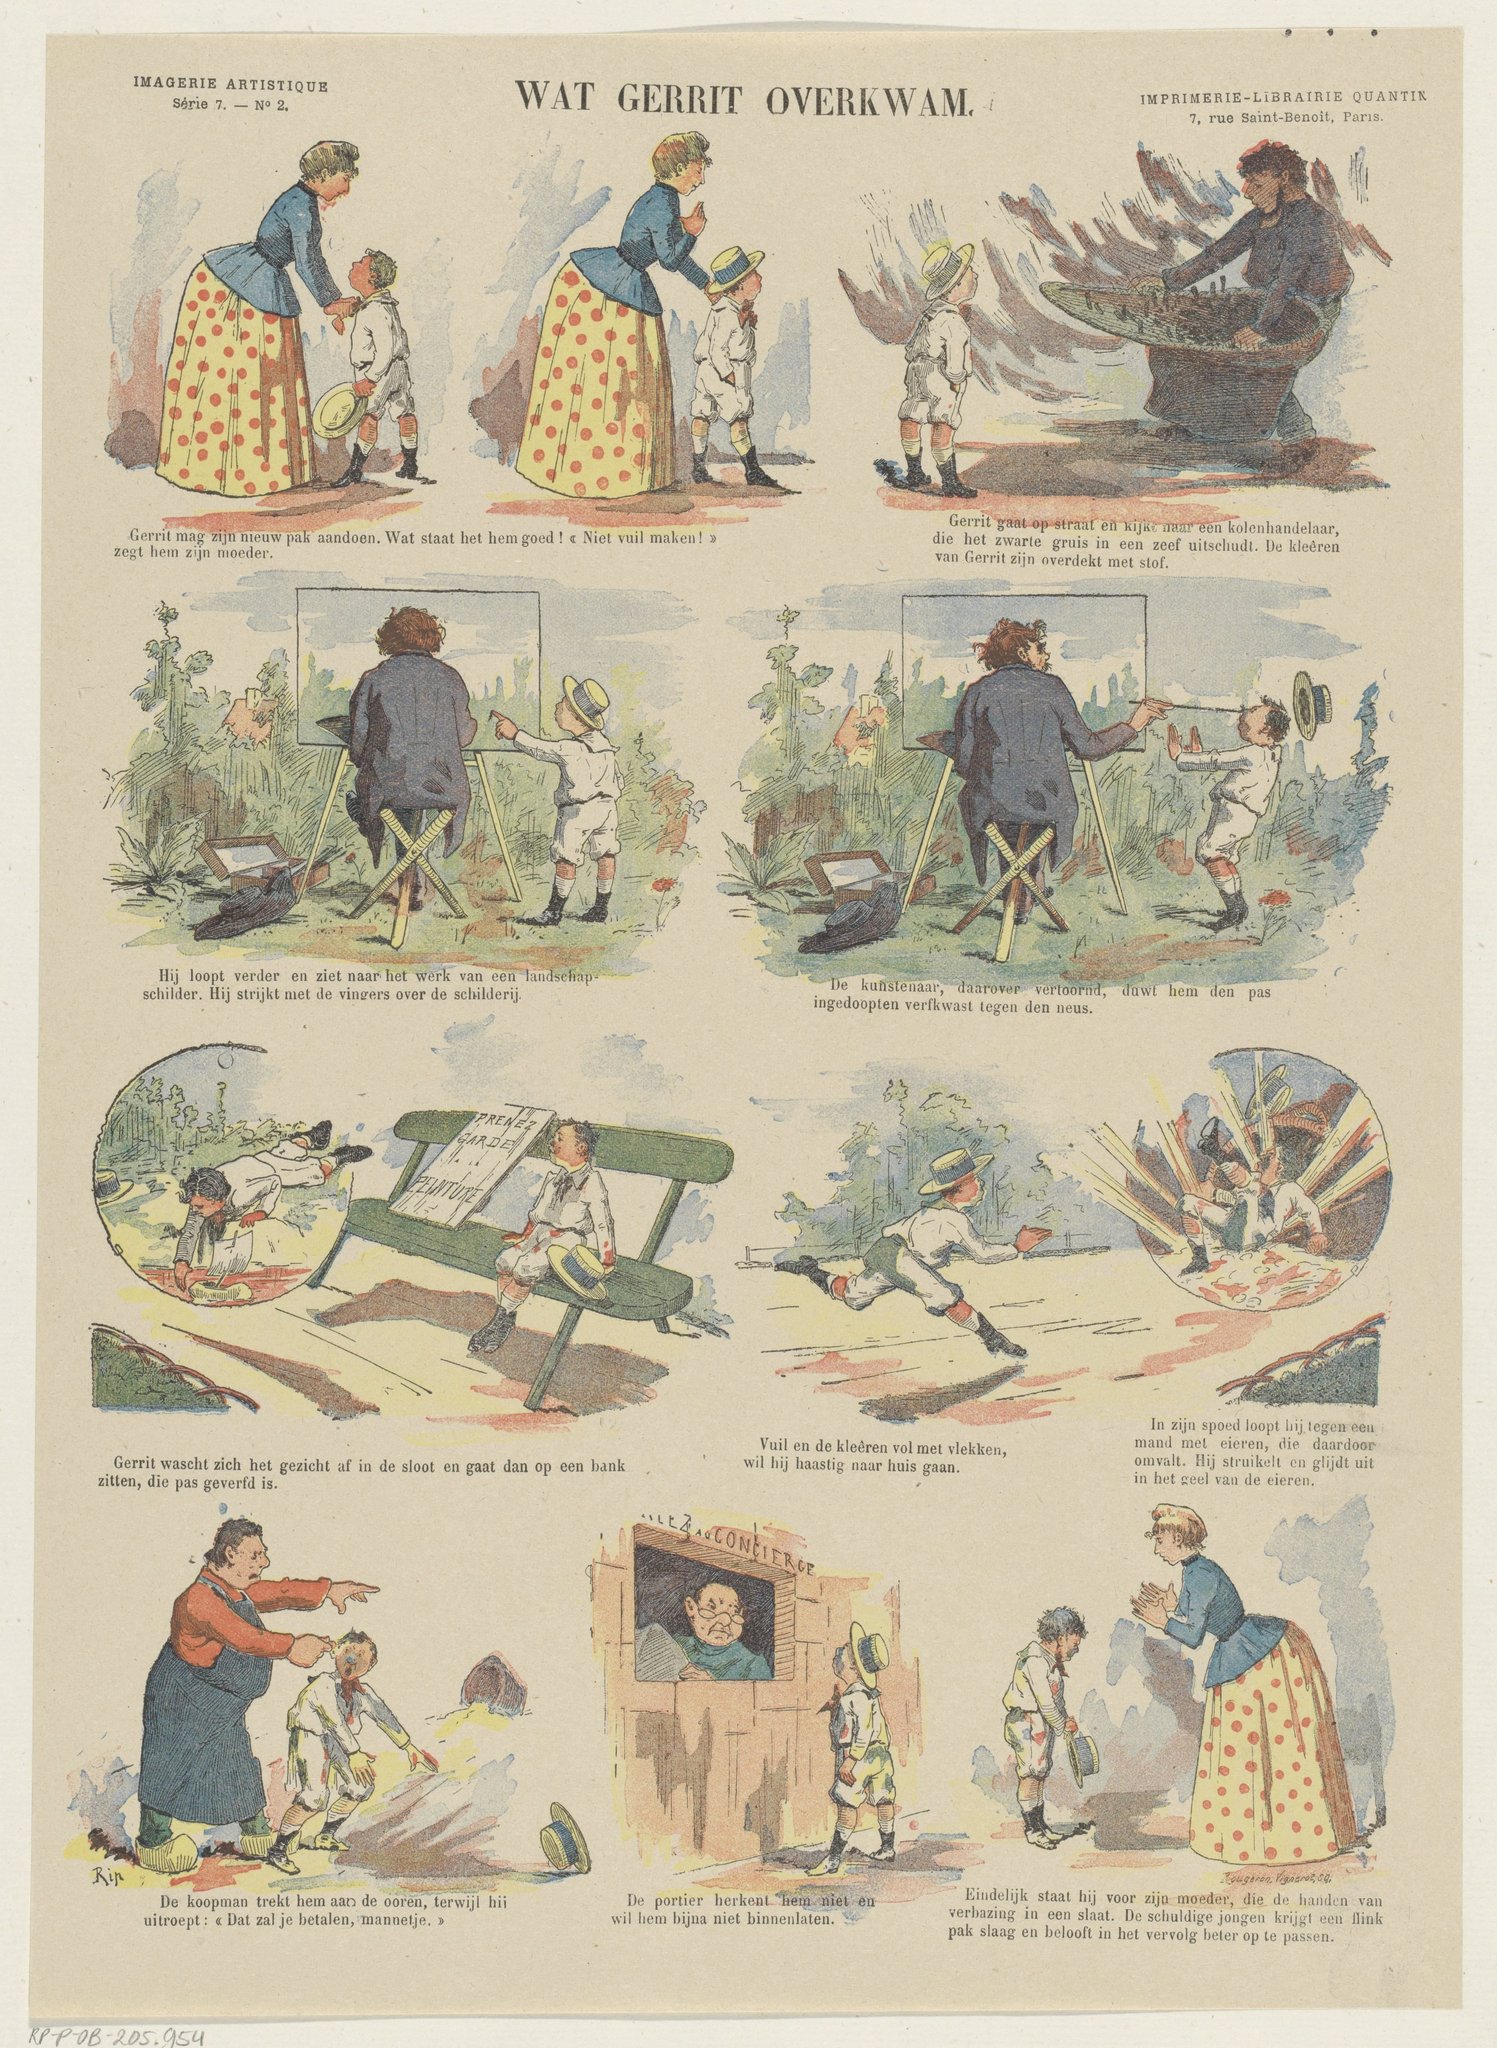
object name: popular print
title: Wat Gerrit overkwam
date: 1876-1890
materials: paper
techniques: lithograph, letterpress printing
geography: paris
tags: adversity, misfortune, bad luck; 'fortuna infelice', 'infortunio' (ripa), tales and fairy tales, clothes, costume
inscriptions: collector's mark: Lugt 2760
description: Blad met 12 voorstellingen van de kleine Gerrit die een nieuw pak krijgt. Het pak wordt erg smerig en Gerrit krijgt straf. Onder elke voorstelling een onderschrift. Genummerd linksboven: Série 7. - No. 2.